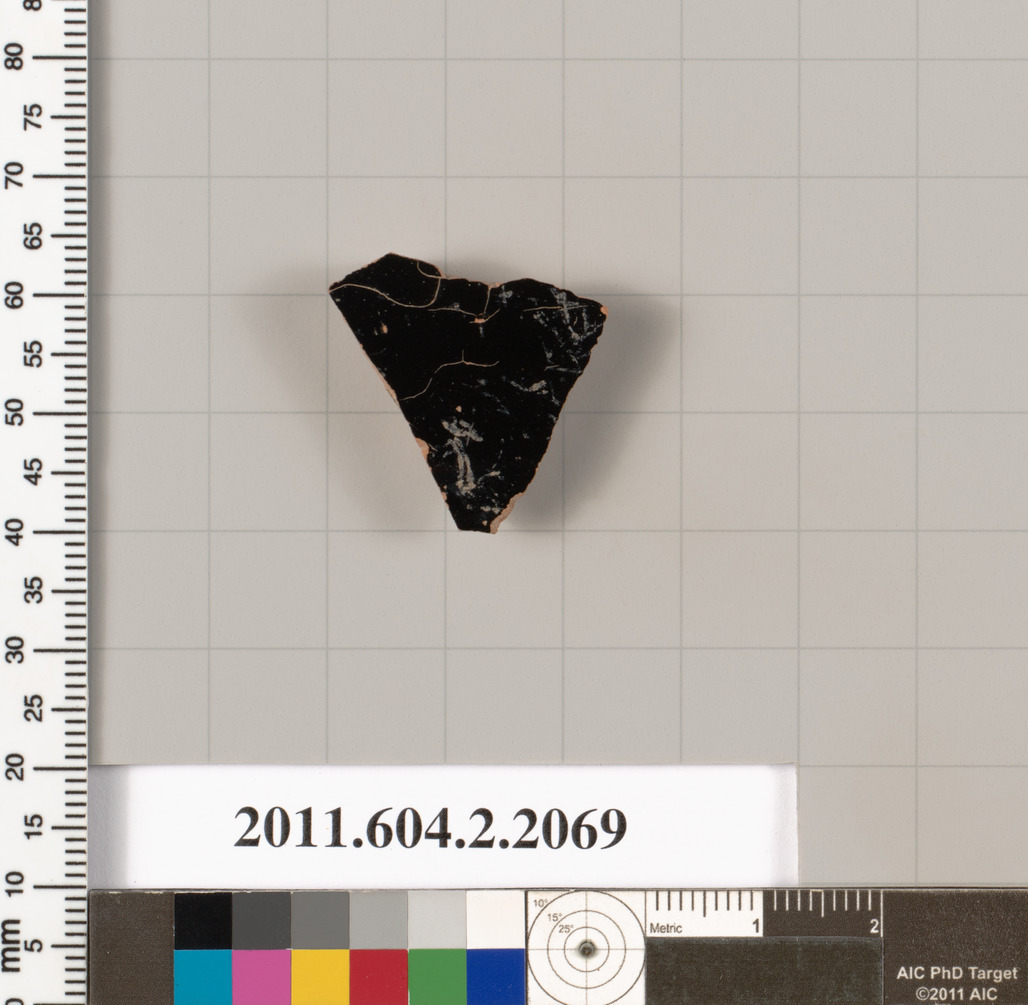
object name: pot fragment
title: Terracotta fragment of a pot; unglazed on the inside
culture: greek, attic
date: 600-401 BCE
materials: terracotta